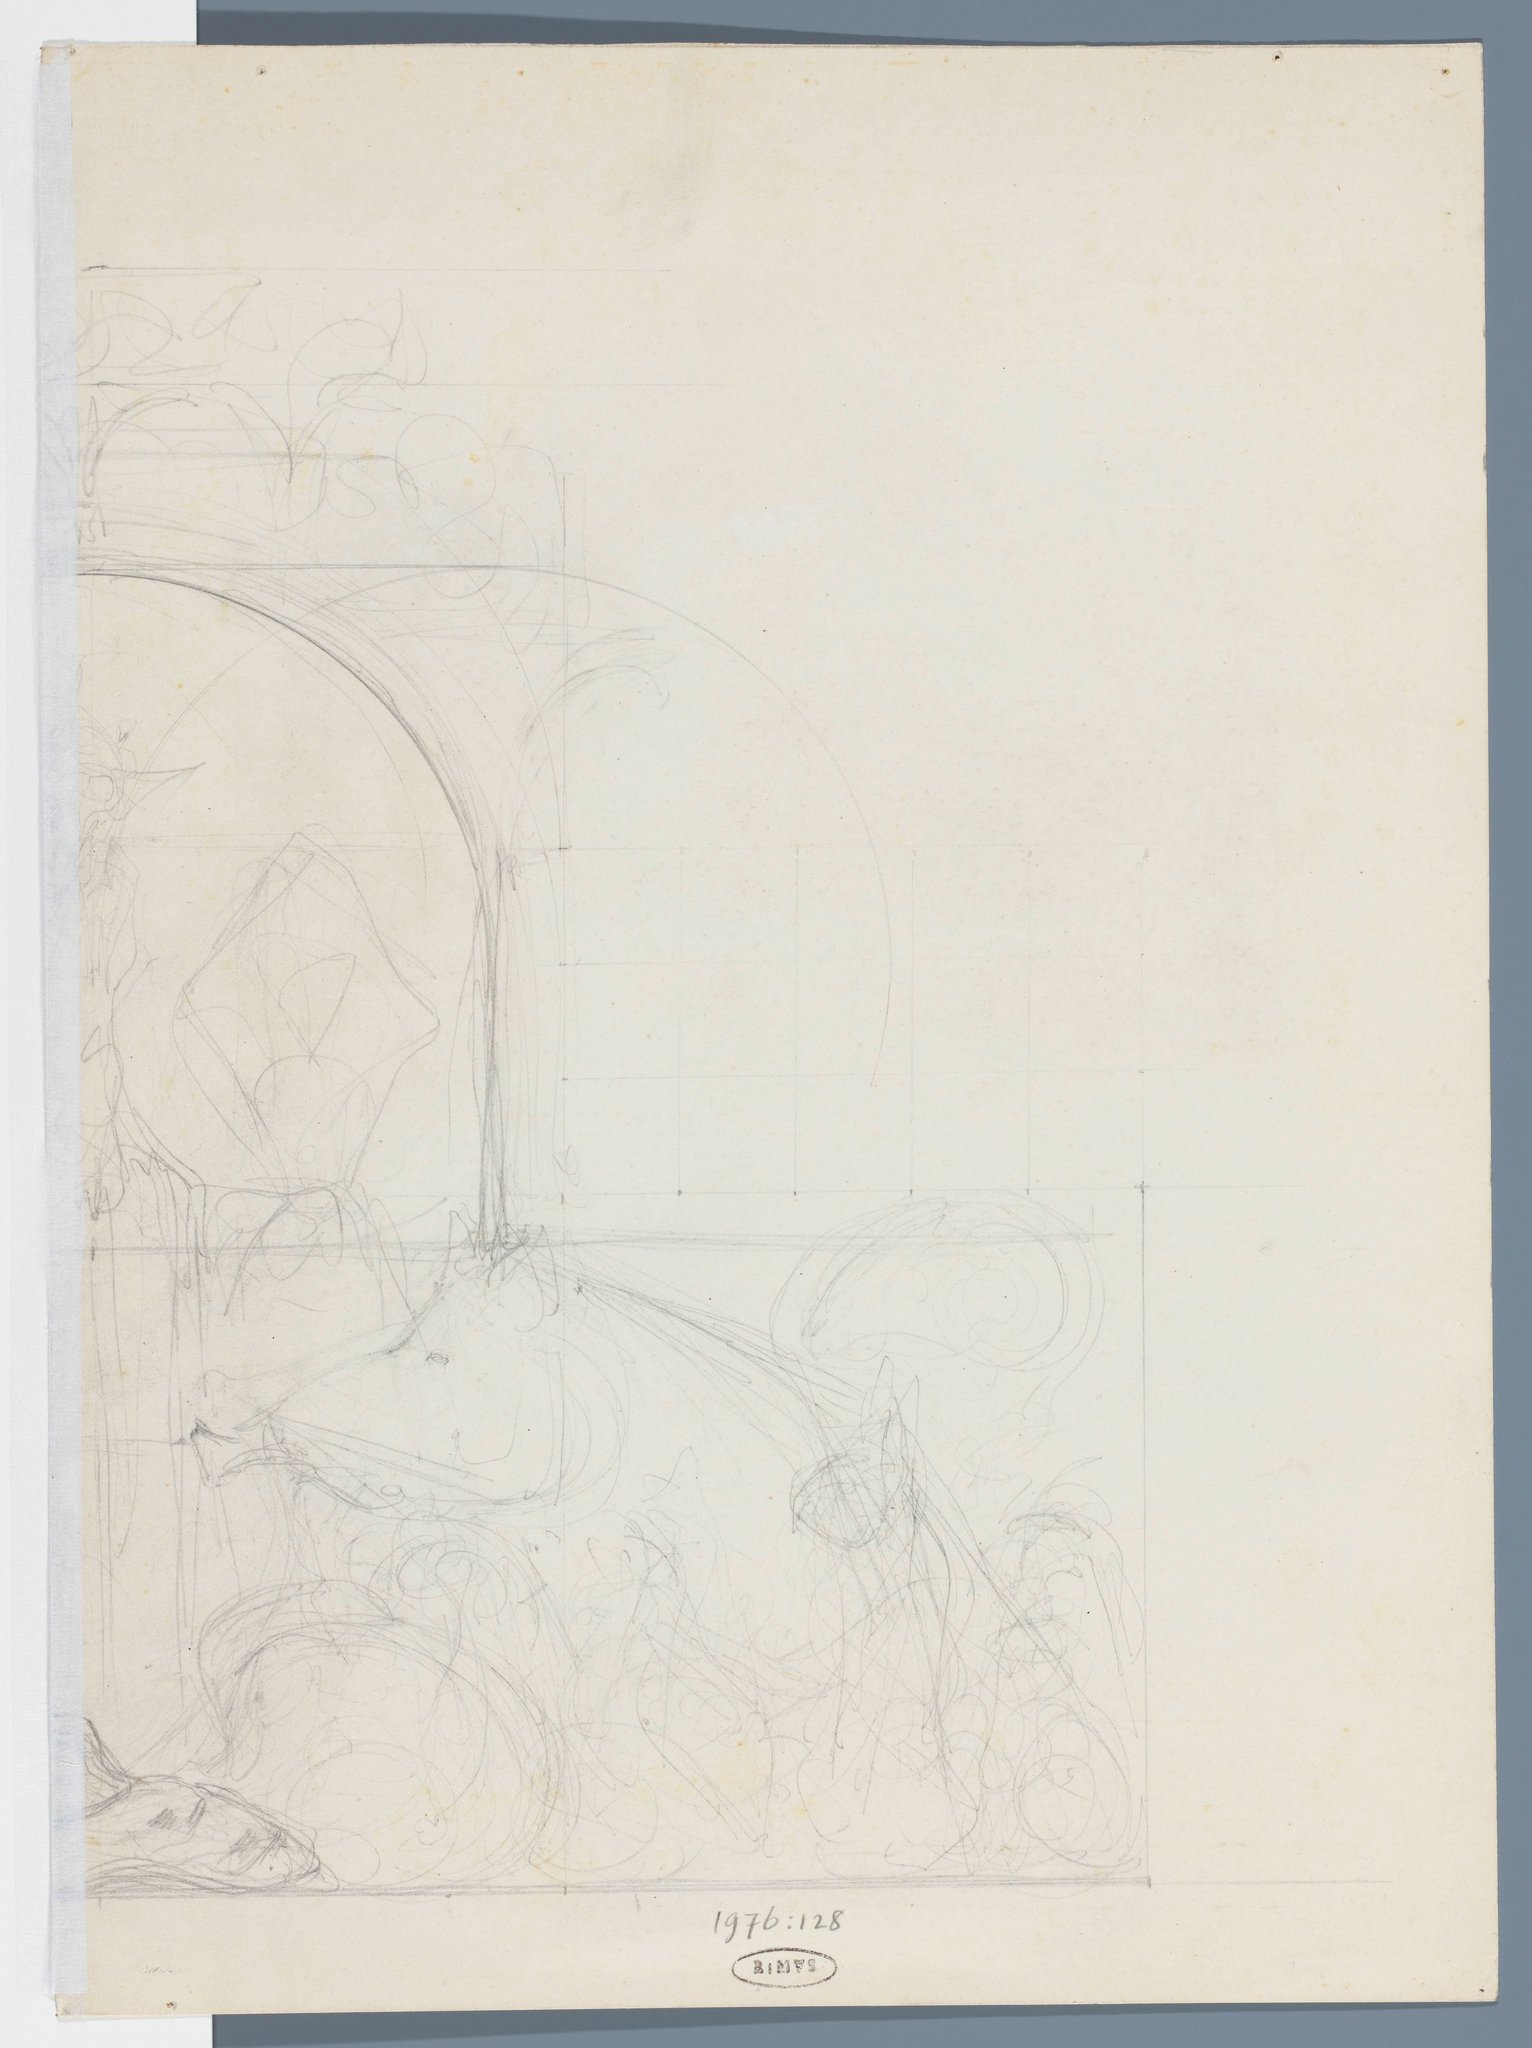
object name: design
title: Schets voor het Titelblad: Van den Vos Reinaerde, De bijeenkomst der dieren voor Koning Nobel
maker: bernard willem wierink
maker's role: draughtsman, print maker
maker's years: 1856-1939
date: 1866-1939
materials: cardboard, pencil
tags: fable of reynard the fox, meeting, assembly - aa - in the open air, groups of animals